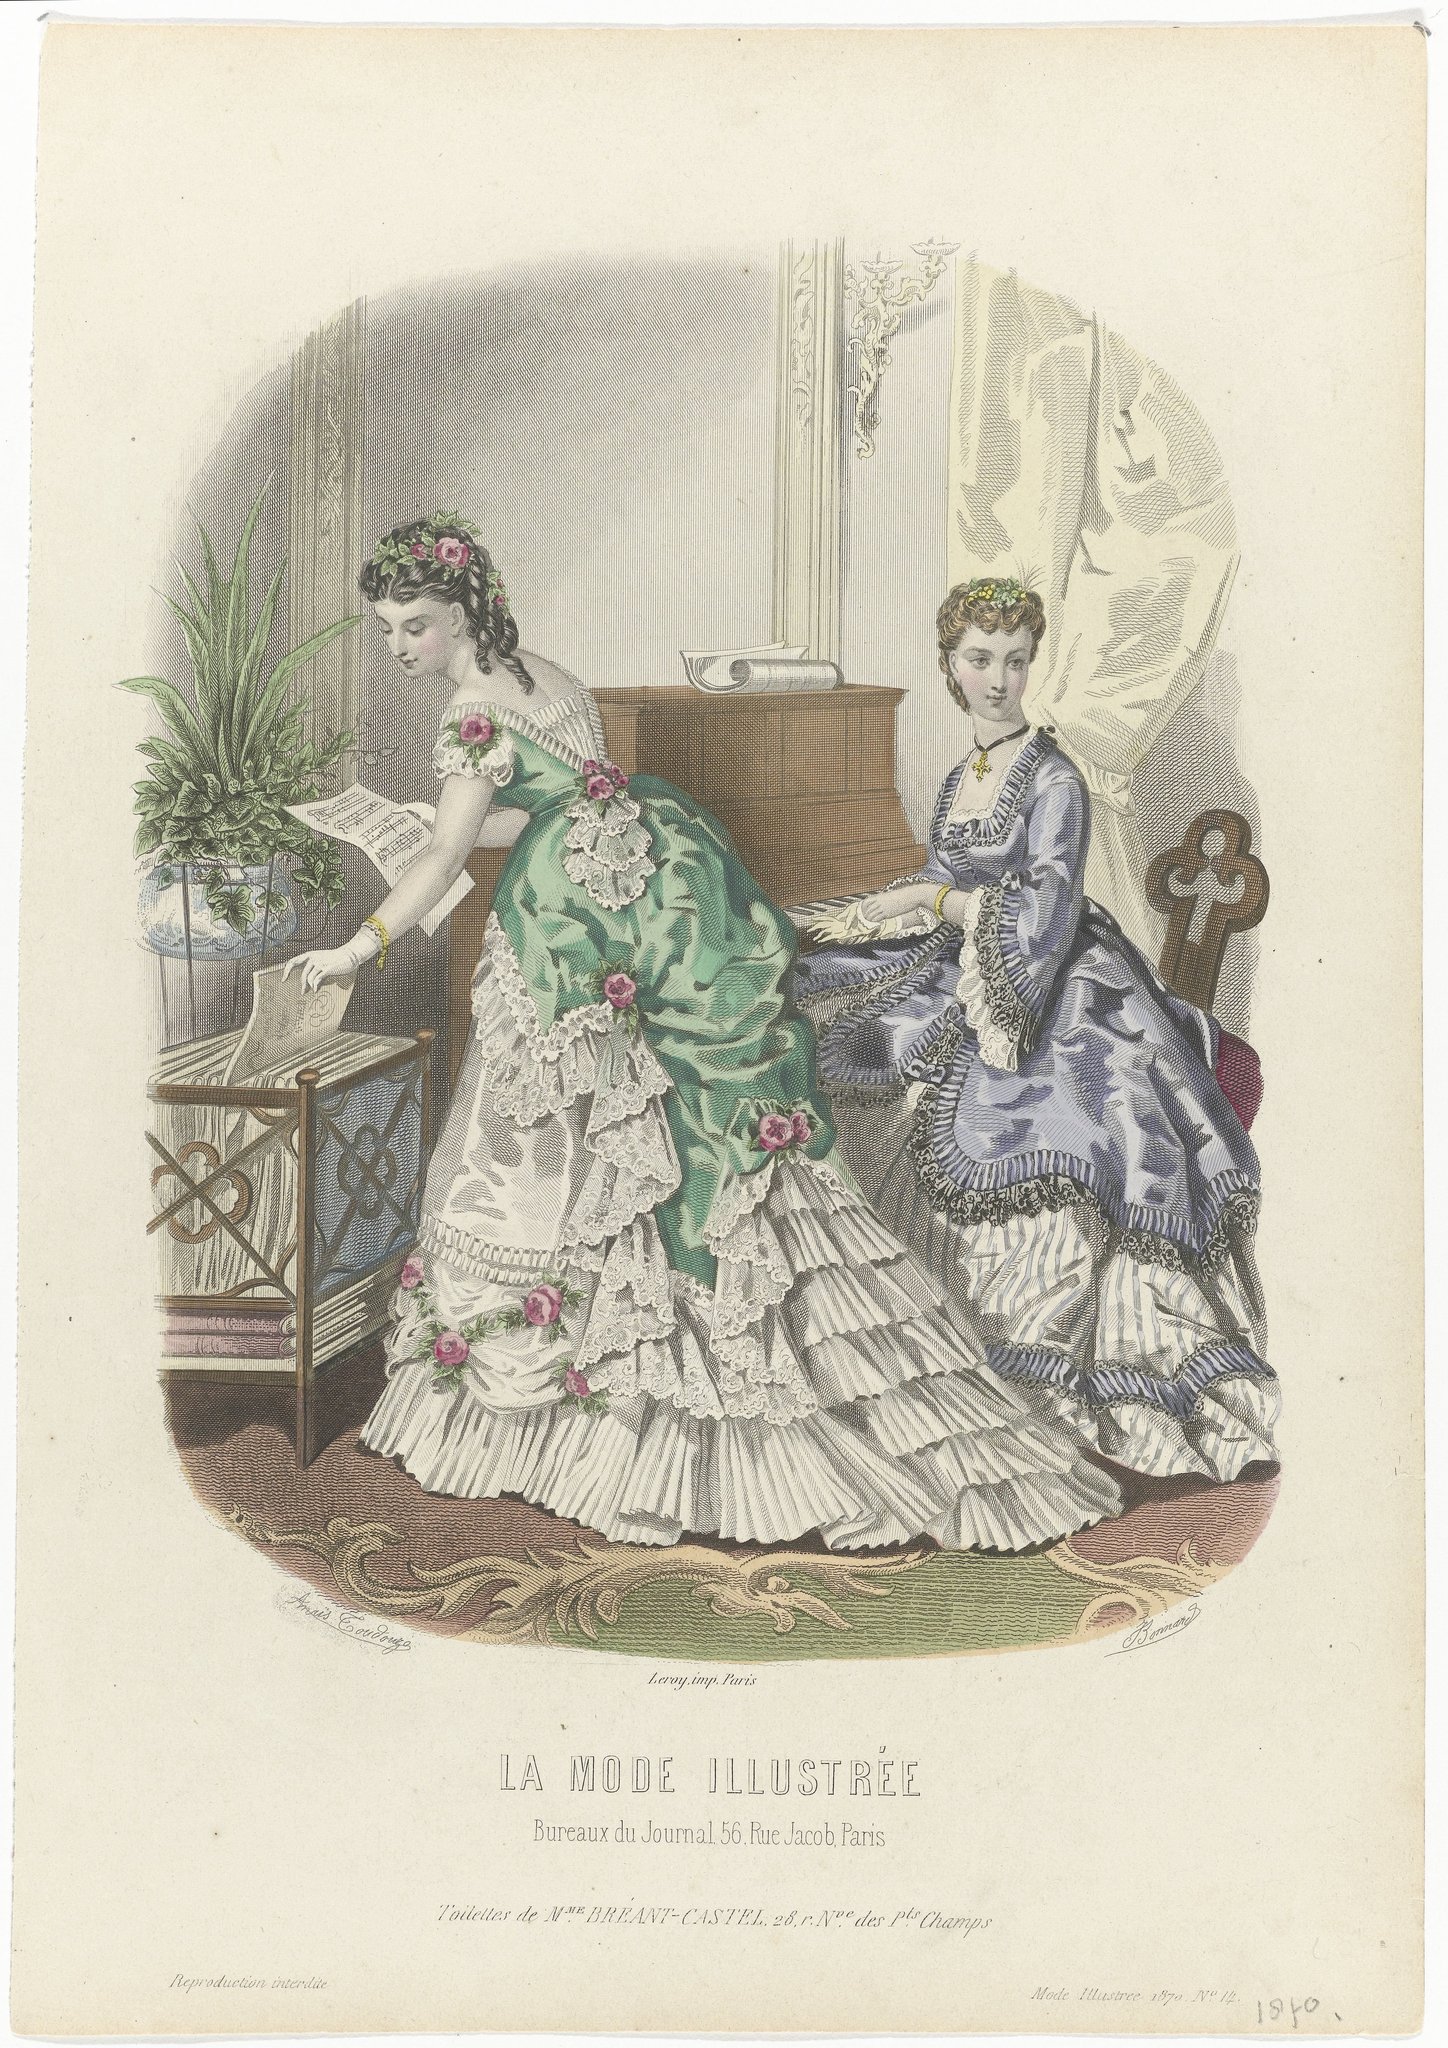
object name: fashion print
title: La Mode Illustrée, 1870, No. 14: Toilettes de Mme Breant-Castel (...)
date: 1870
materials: paper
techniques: engraving, hand coloring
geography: paris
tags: pendant, trinket, 'breloque' (+ women's clothes), notation of music, gloves, mittens, etc. (+ undressing, taking off clothes), fashion plates, dress, gown (+ women's clothes), bracelet, wristlet (+ women's clothes), pianoforte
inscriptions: address: ‘Bureaux du Journal, 56, Rue Jacob. Paris’, title: ‘La Mode Illustrée’, caption: ‘Toilettes de Mme Bréant-Castel, 28, r. Nve des Pts Champs’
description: Twee vrouwen in een interieur, bij een piano en kast met bladmuziek, gekleed in avondjaponnen van Bréant- Castel. Prent uit het modetijdschrift La Mode Illustrée (1860-1937).